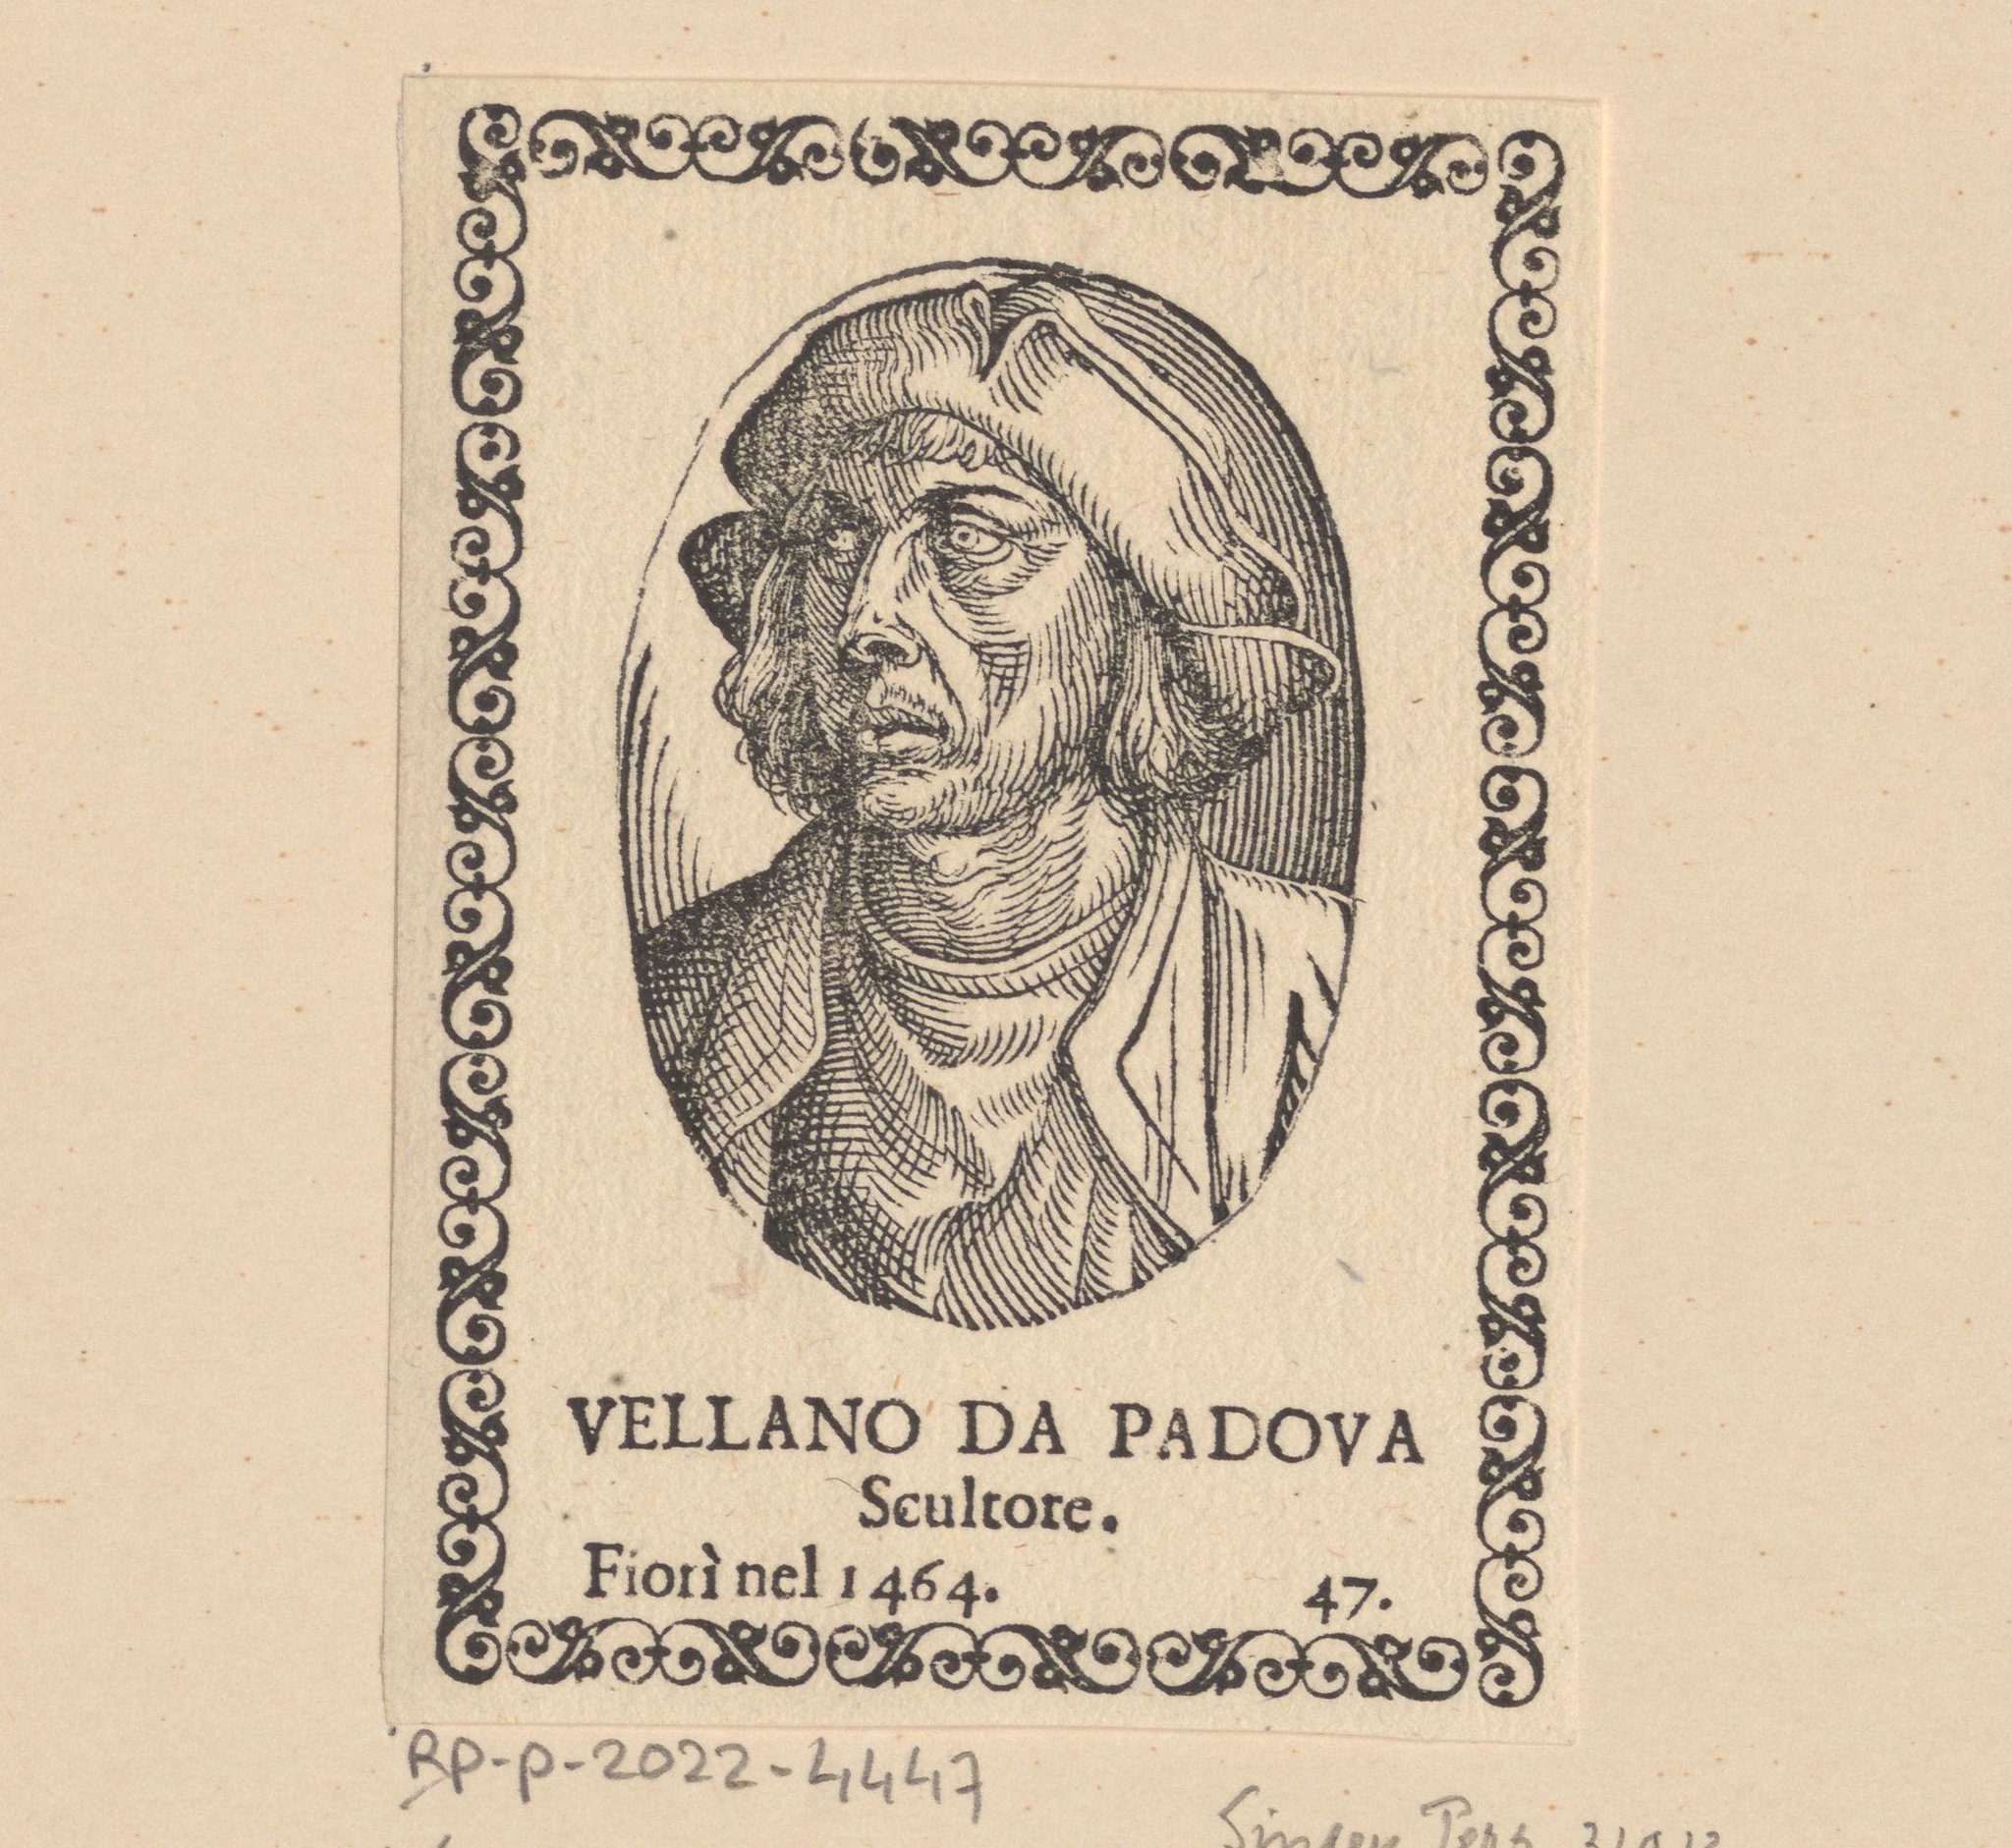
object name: print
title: Portret van Bartolomeo Bellano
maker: cristoforo coriolano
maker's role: print maker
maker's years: 1540-1610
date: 1568-1650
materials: ink, paper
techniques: letterpress printing, pen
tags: sculptor, bartolomeo bellano, portrait, self-portrait of sculptor, historical persons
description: Prent komt uit een editie van Vasari's 'Vite'. Prent met een andere omlijsting is gebruikt in de editie uit 1568: Vasari, Giorgio. Le vite de' piu eccellenti pittori scultori, e architettori. Florence: Filippo Giunta, 1568. En mogelijk in de editie uit 1647.